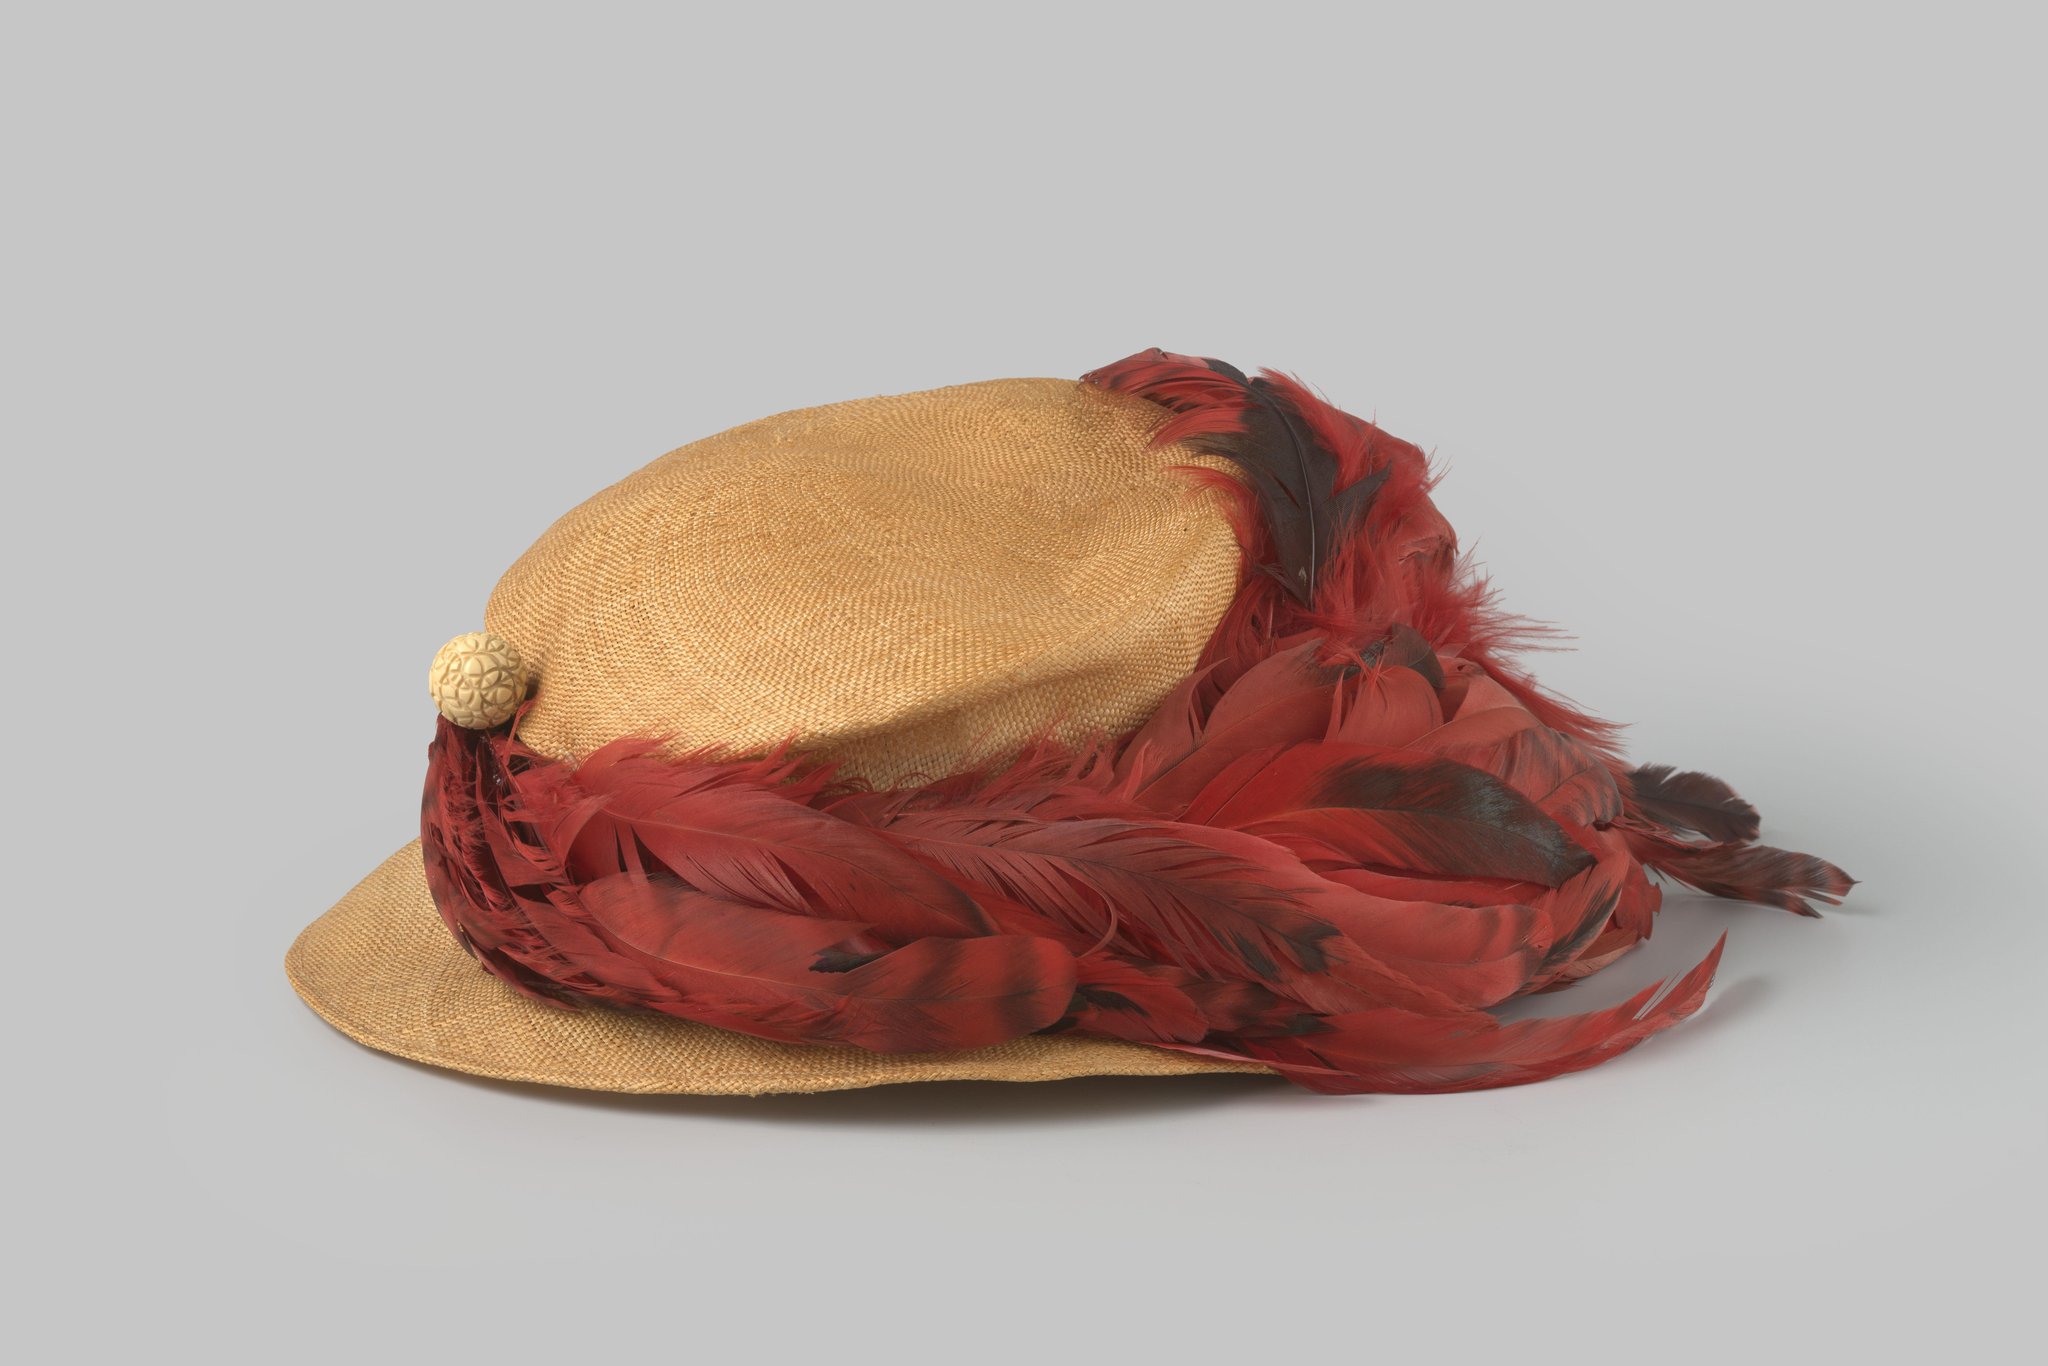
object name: hat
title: Hoed van fijn naturelstro met verentooi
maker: Anonymous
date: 1930-1940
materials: feather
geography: brussels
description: Hoed van fijn naturelstro met verentooi. Middelhoge cylindrische bol, bij de overgang naar het bovenvlak van voren scherp gevouwen en iets vooruitspringend uitgebogen. De rand is van voren en opzij breder dan vanachter, waar hij neergeslagen is. Krans van oranje tot terra rood geverfde hanenveren om de bol, vervolgt als een opstaande verentoef. Adres (op het zwarte binnen entrée-lintje, zeer vervaagde letters): GAMEX/DE LUXE (?).